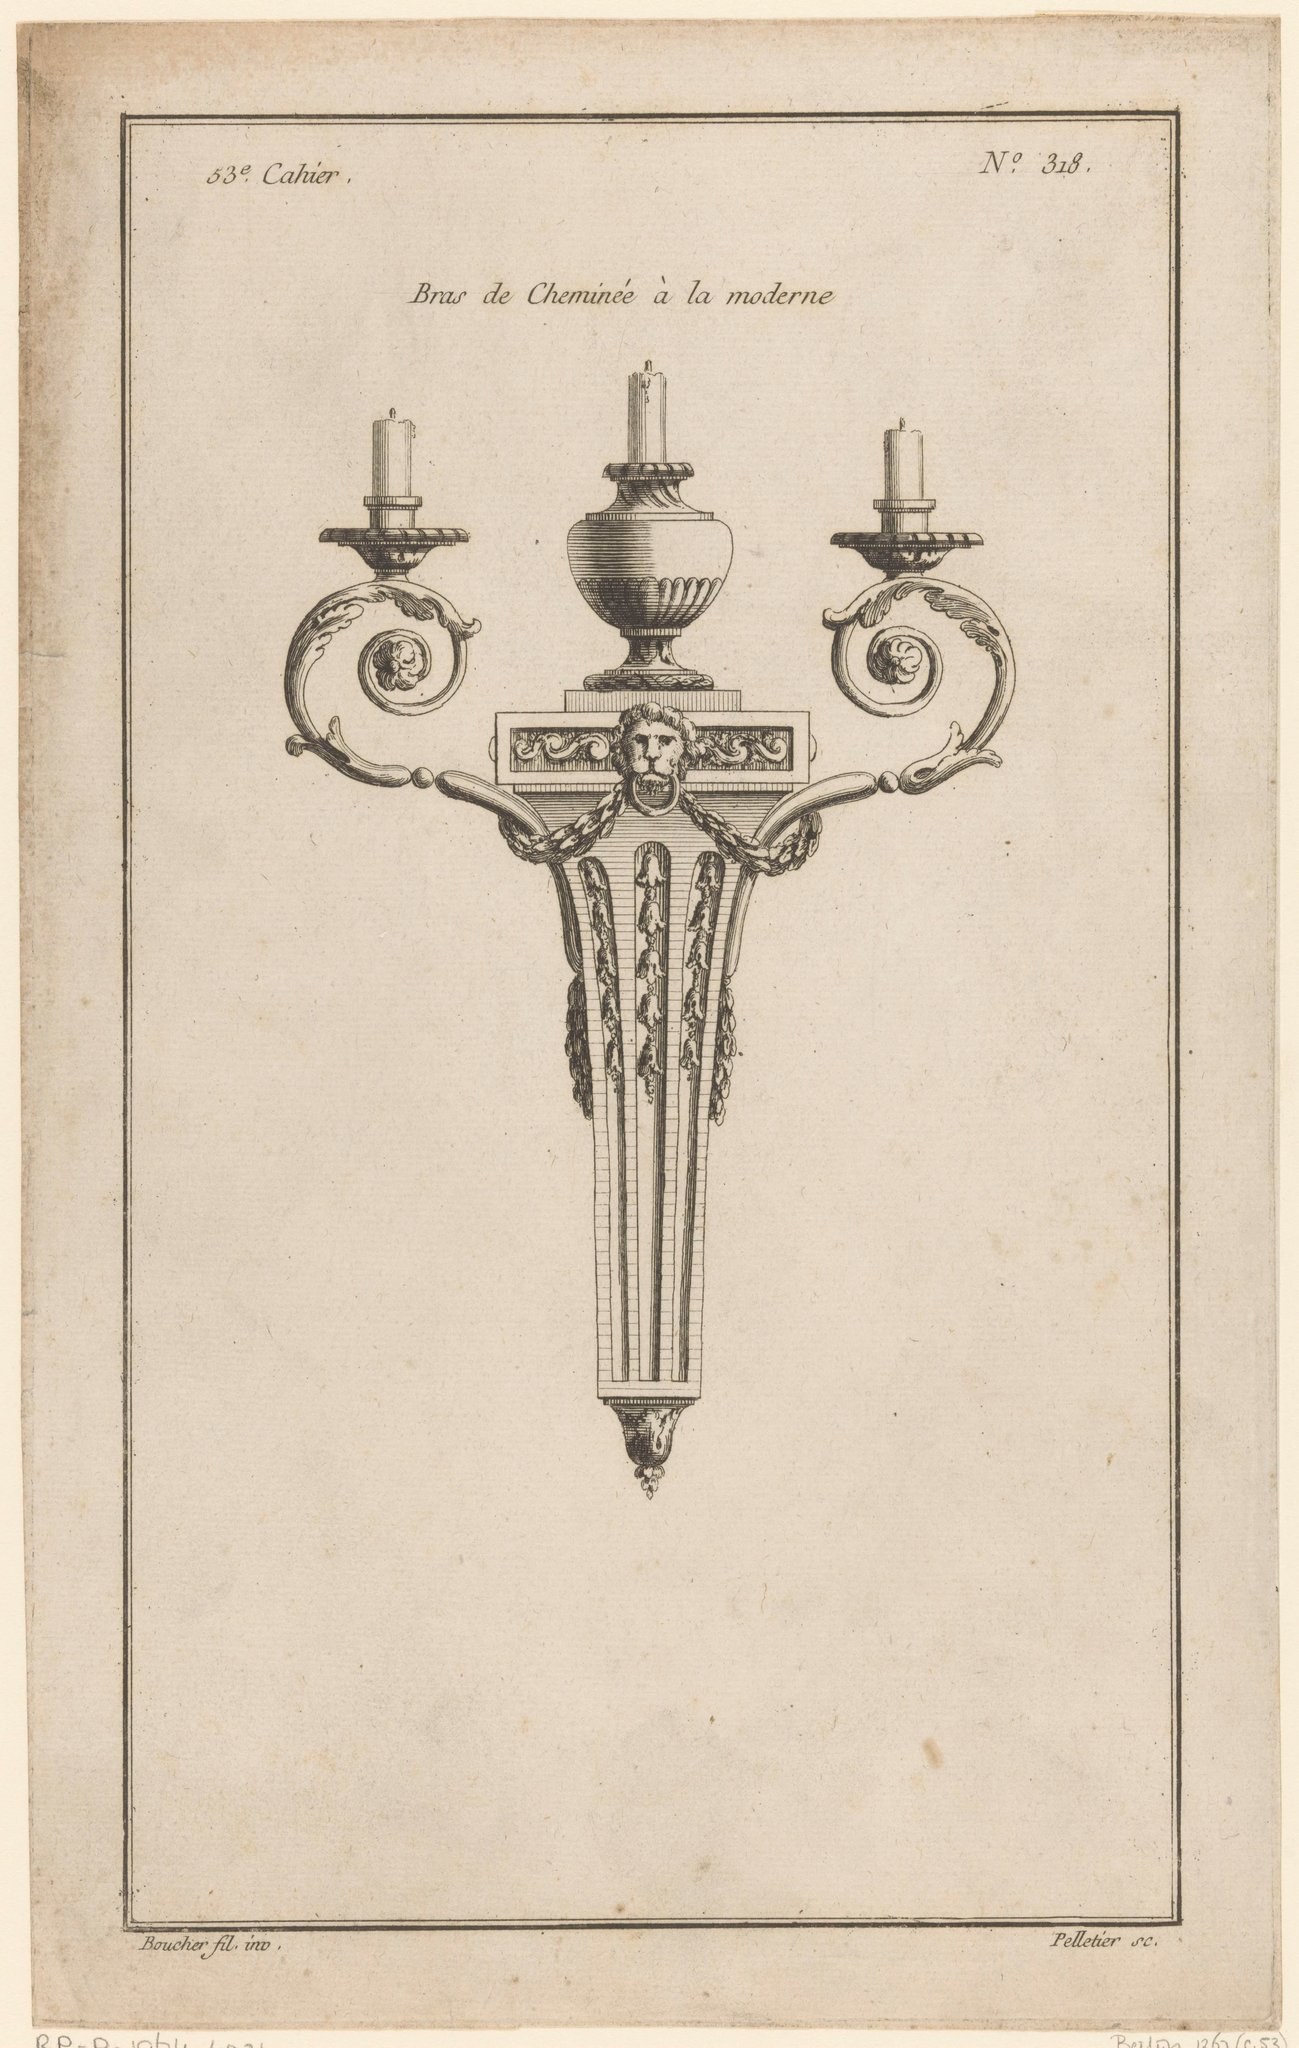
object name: ornament print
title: Bras de Cheminée à la moderne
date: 1772-1779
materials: paper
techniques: engraving, etching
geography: paris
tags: lion's head ~ ornament, sconce, wall lamp, vase ~ ornament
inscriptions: collector's mark: Lugt 2760, collector's mark: Lugt 2228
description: Een tweearmige wandkandelaar met een derde kaars in een vaas en een leeuwenkop. Prentnummer 318.